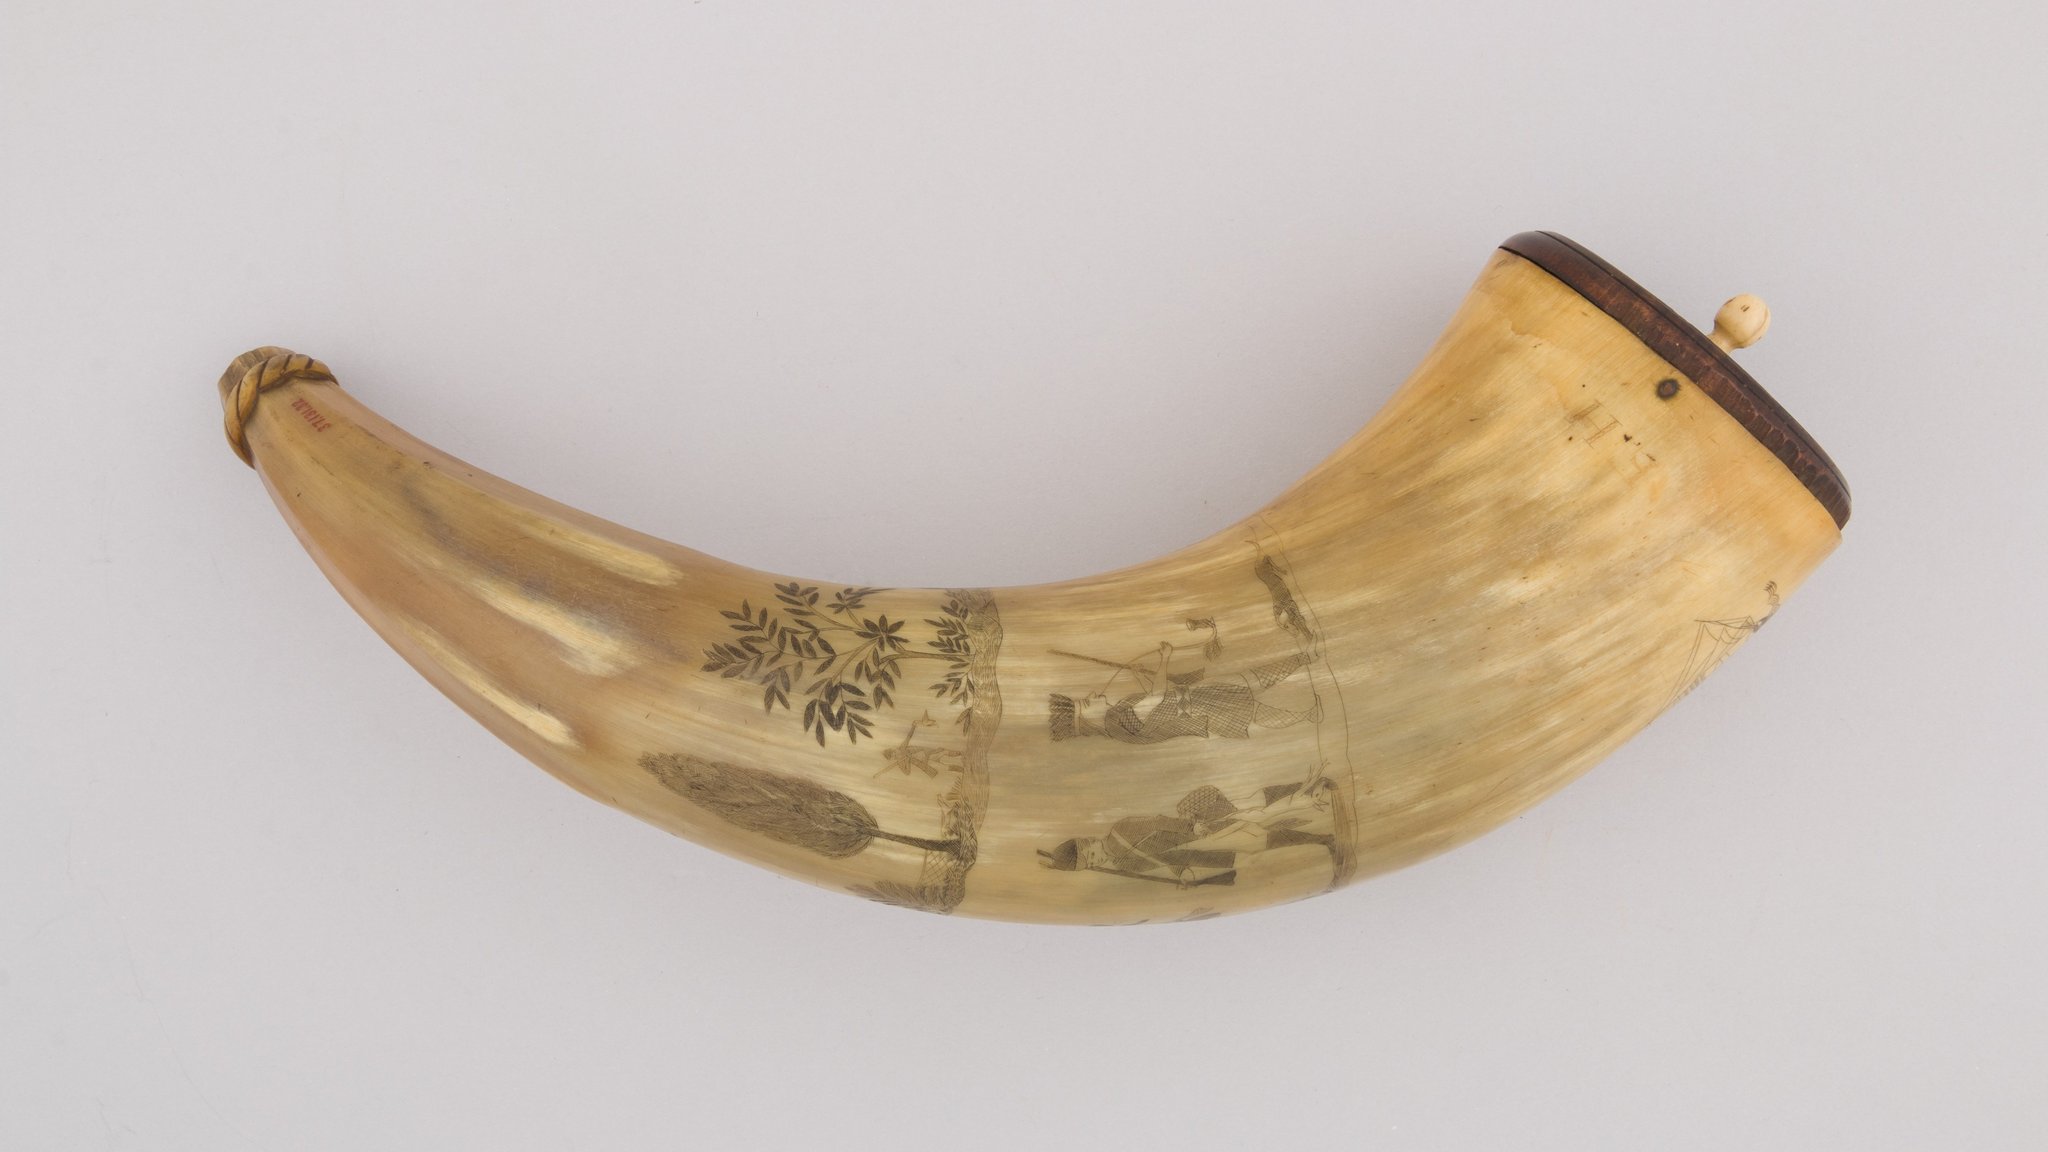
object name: powder horn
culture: american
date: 1775-1800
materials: horn, wood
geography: united states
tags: men,hunting,dogs